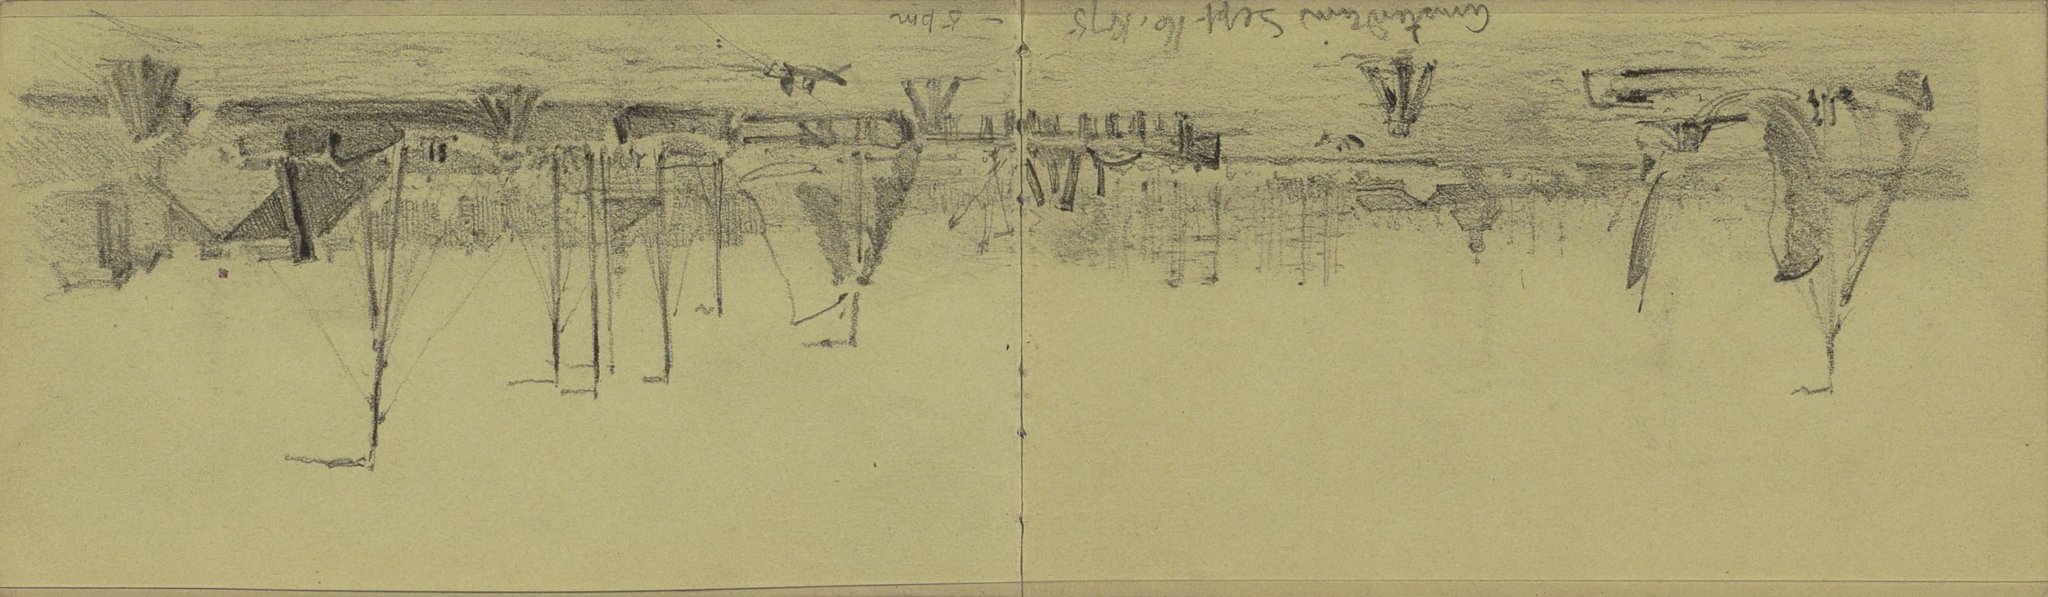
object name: sketchbook leaf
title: Gezicht op de haven van Amsterdam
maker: george clausen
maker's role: draughtsman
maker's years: 1852-1912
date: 1809-1875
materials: paper, pencil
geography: amsterdam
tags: harbour, sailing-ship, sailing-boat, amsterdam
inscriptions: date and inscription: ‘Amsterdam Sept [...] 1875 - 5 pm’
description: Blad 35 verso en 36 recto uit een schetsboek met 46 bladen.